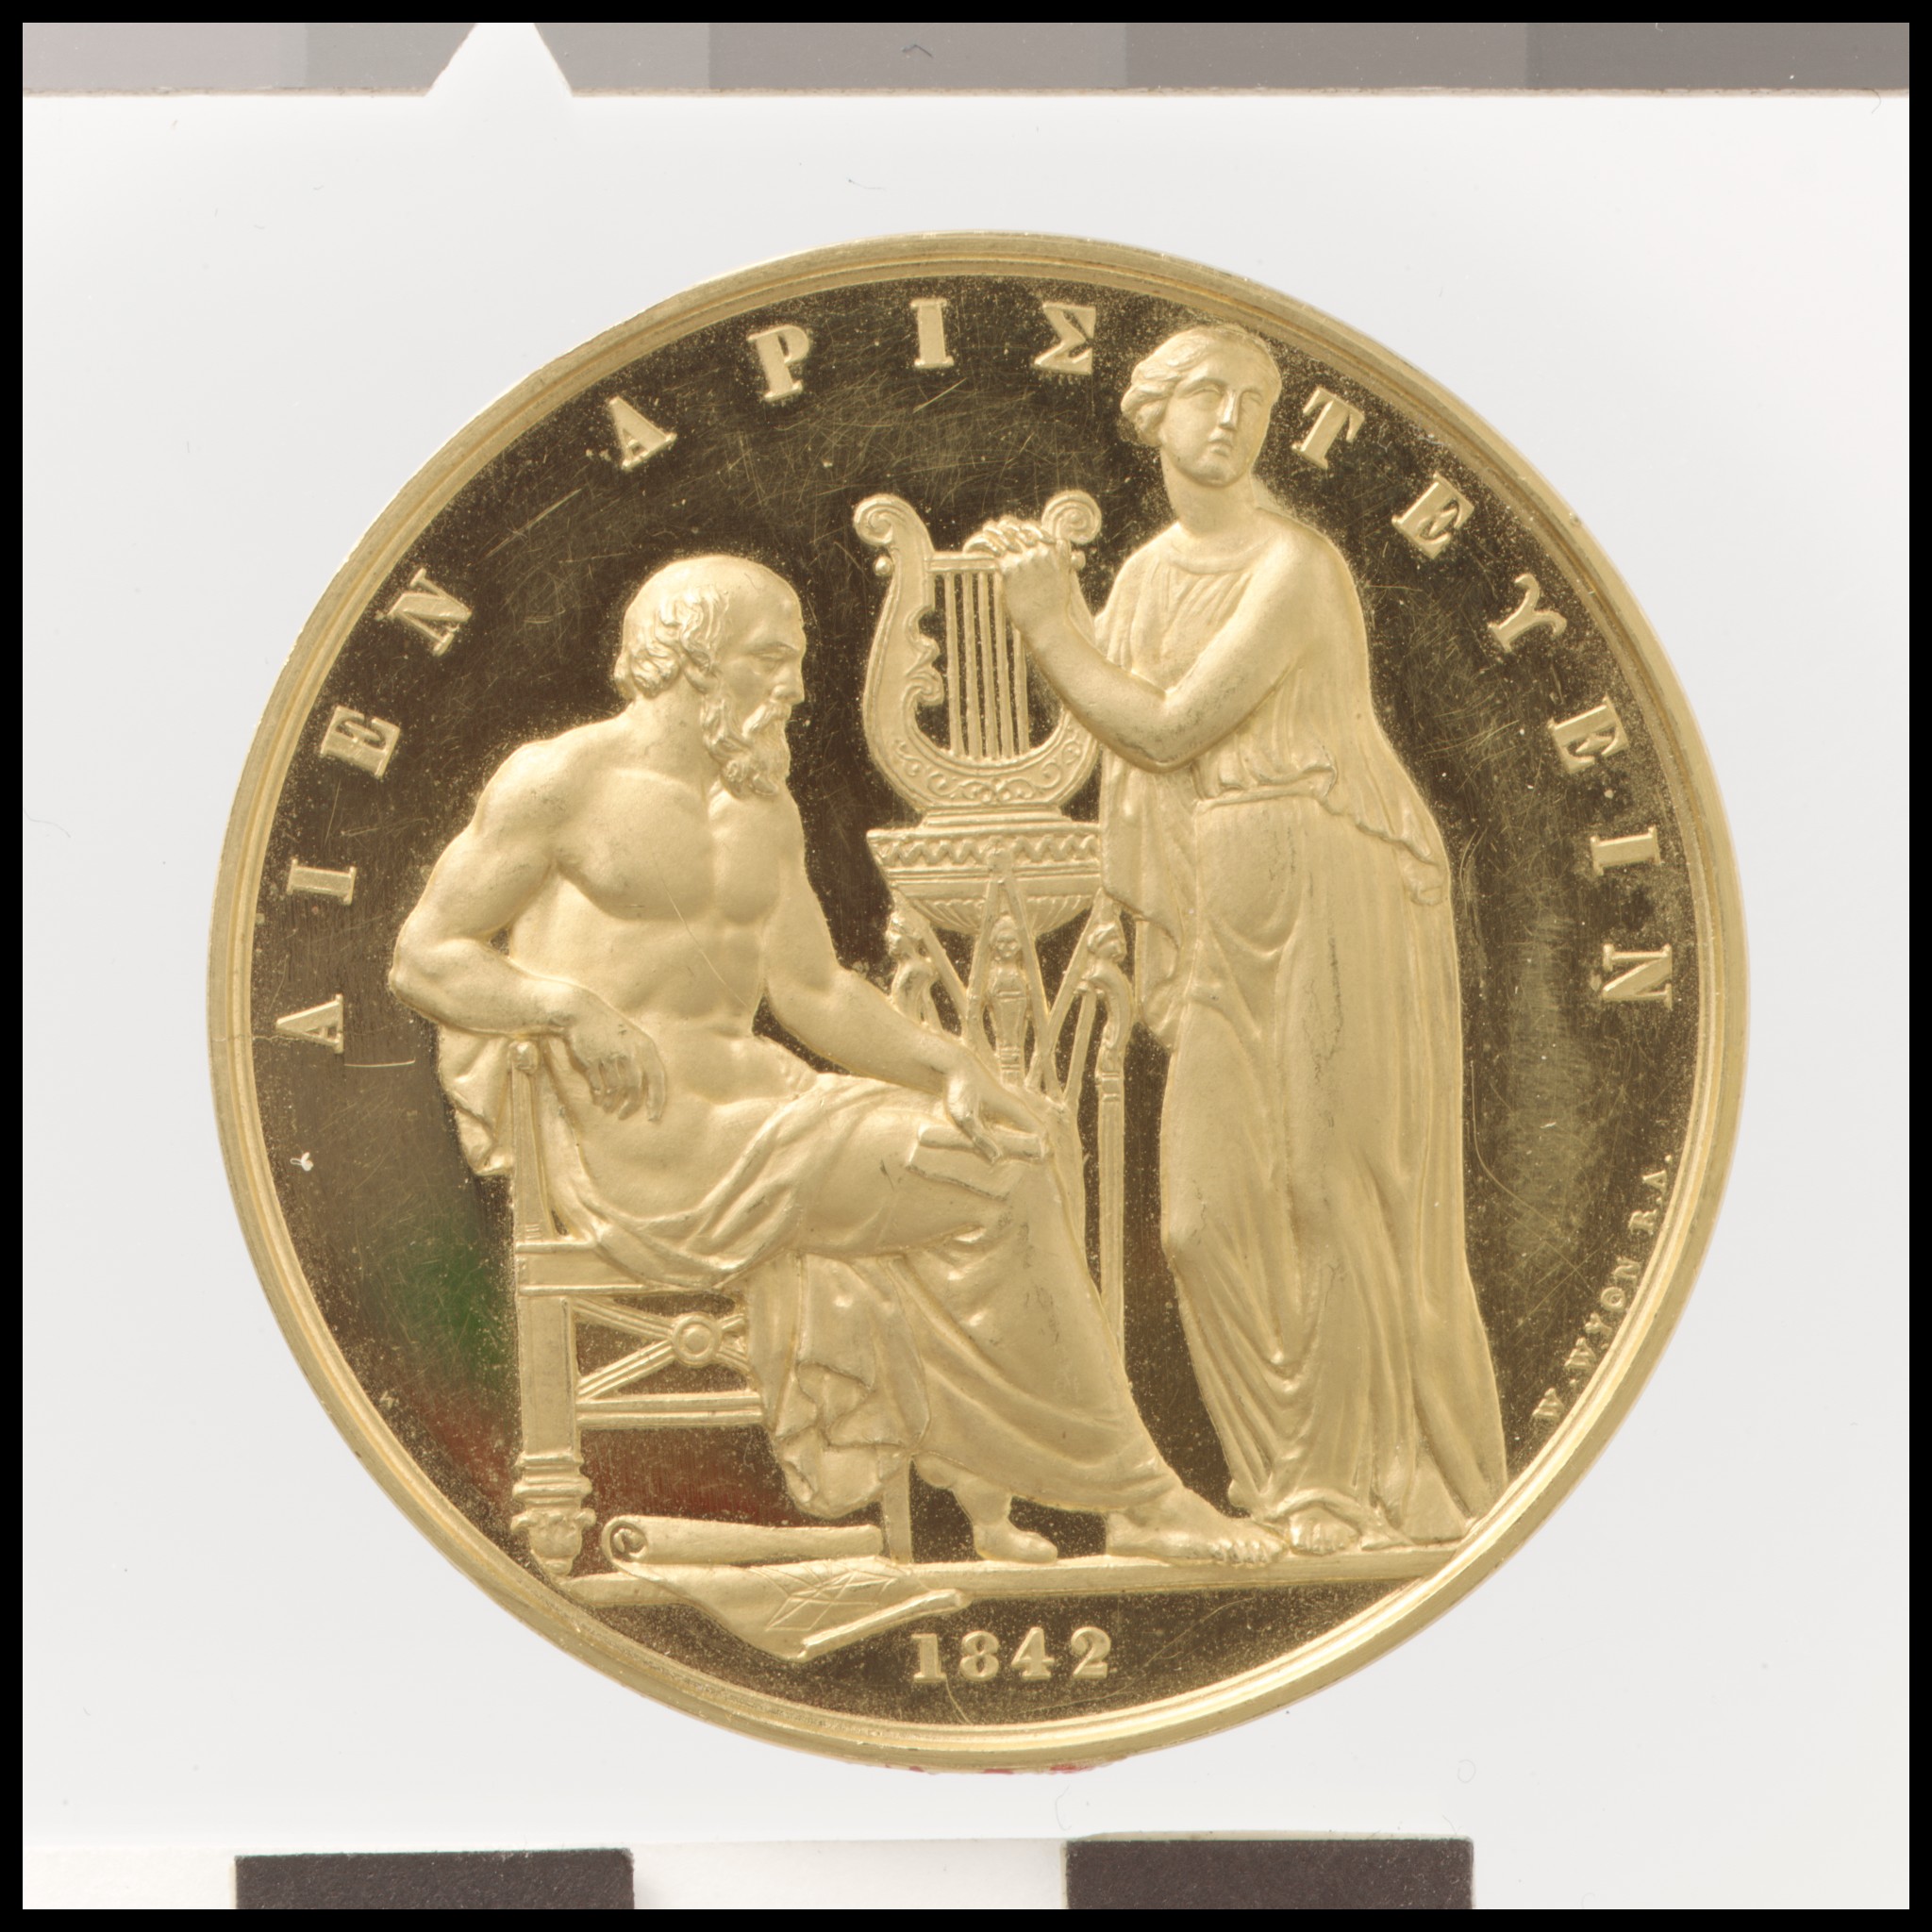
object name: medal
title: Wrangham Medal for Cambridge University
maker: william wyon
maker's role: artist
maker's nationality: british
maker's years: 1795-1851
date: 1842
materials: gold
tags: men,women,harps,flowers